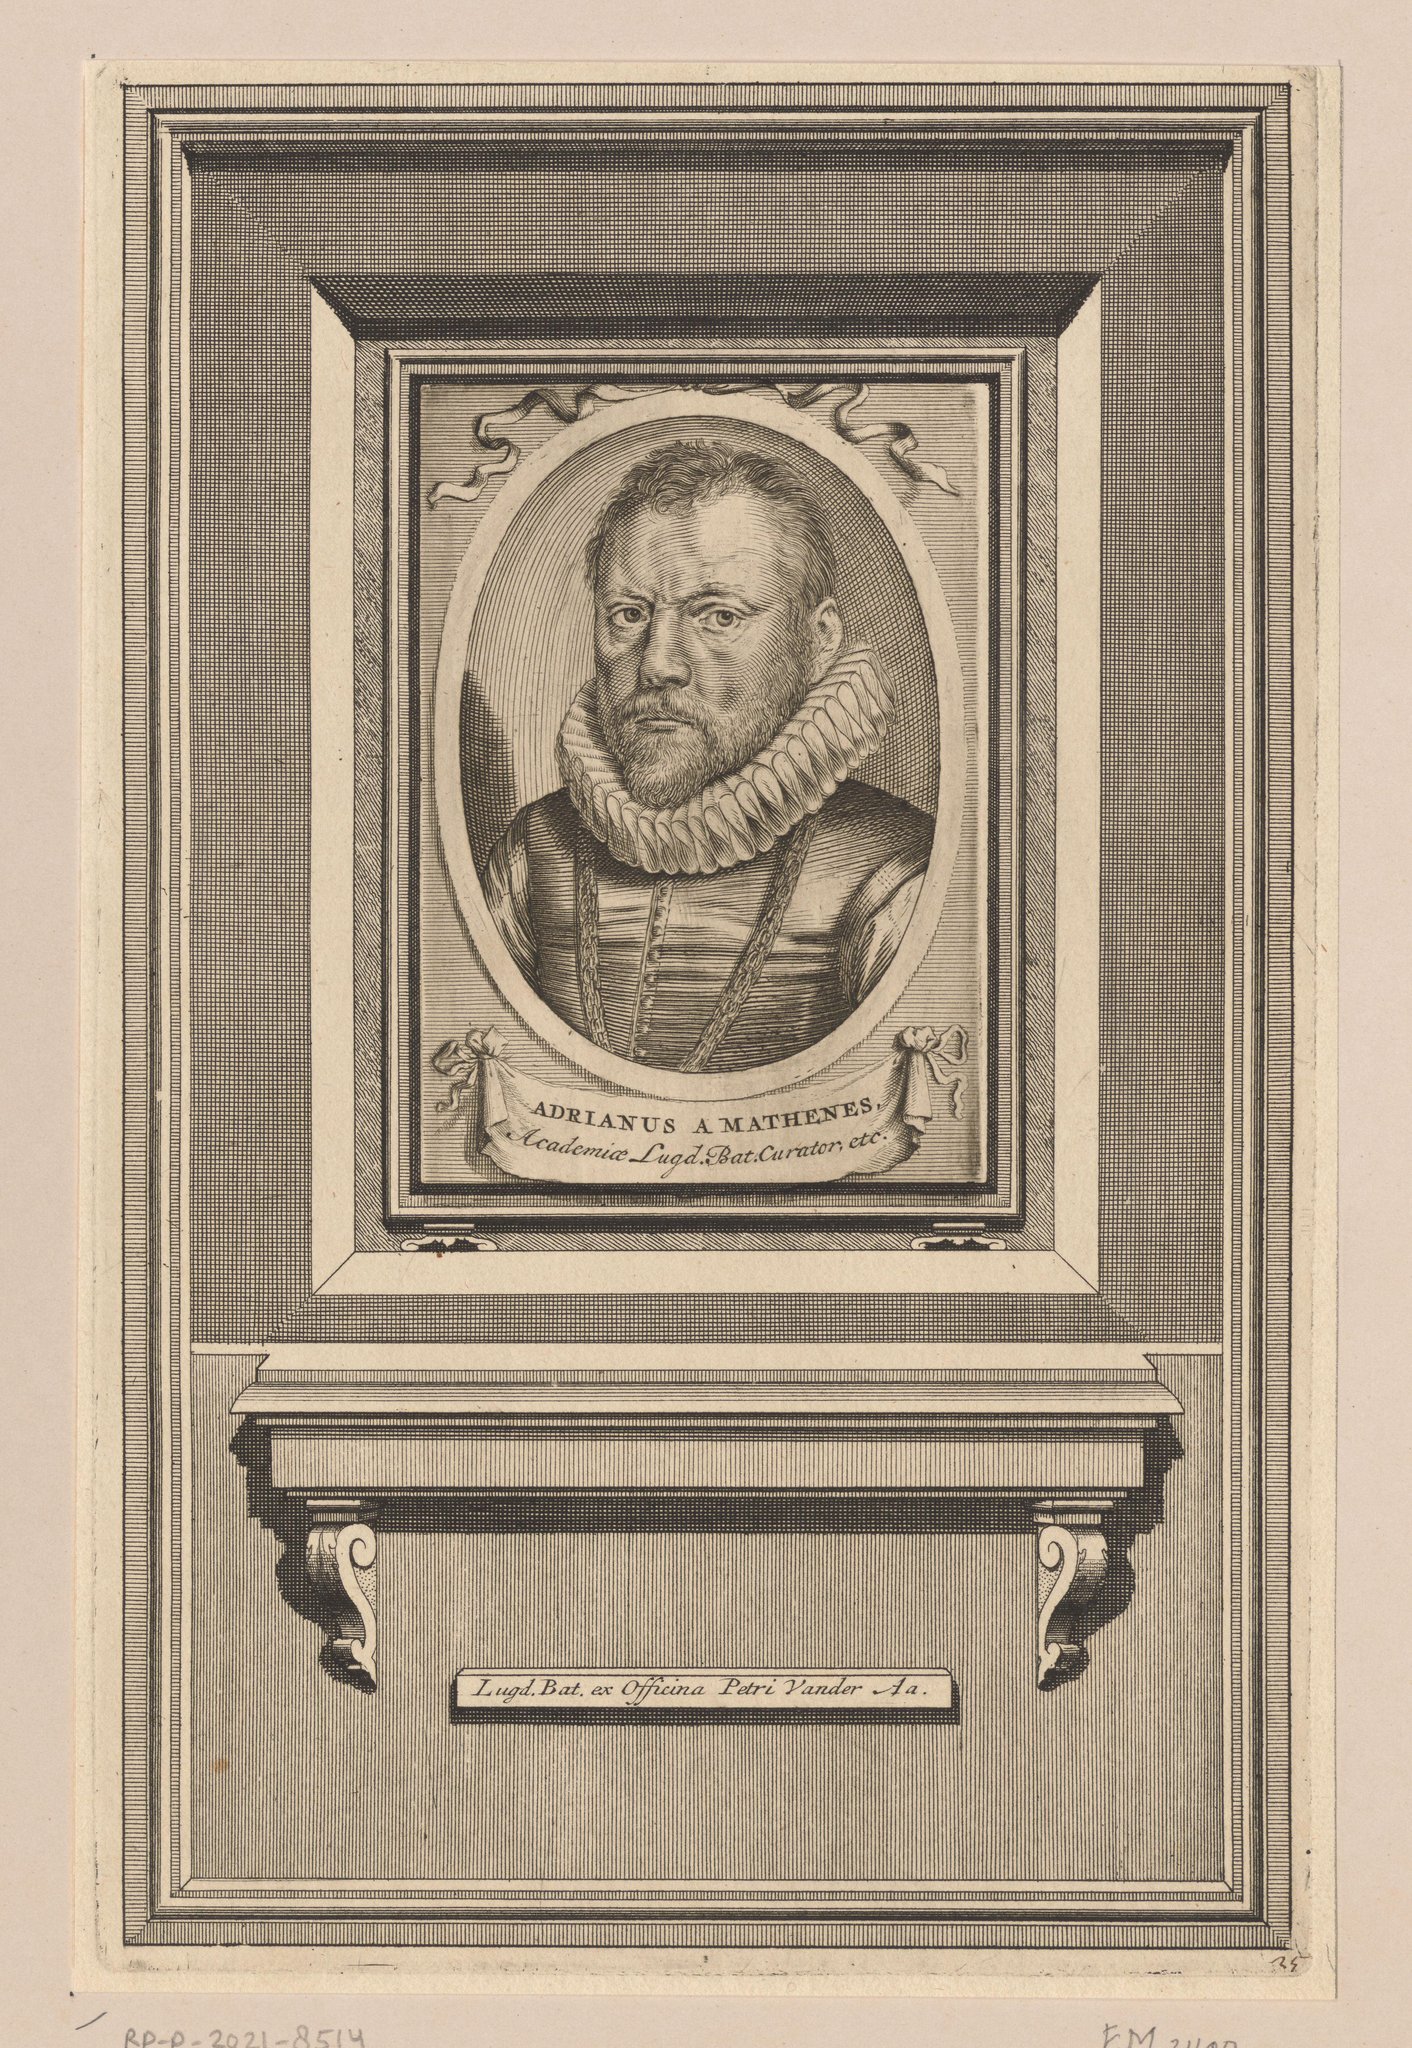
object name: print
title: Portret van Adriaan van Mathenes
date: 1716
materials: paper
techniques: engraving, etching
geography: leiden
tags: ornament ~ medallion, historical persons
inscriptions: number: ‘25’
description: Prent in eerdere staat gebruikt voor: Meursius, Joannes. Illustrium Hollandiae & Westfrisiae Ordinum Alma Academia Leidensis. Leiden: Jacob Marcus & Joost van Colster, 1614.